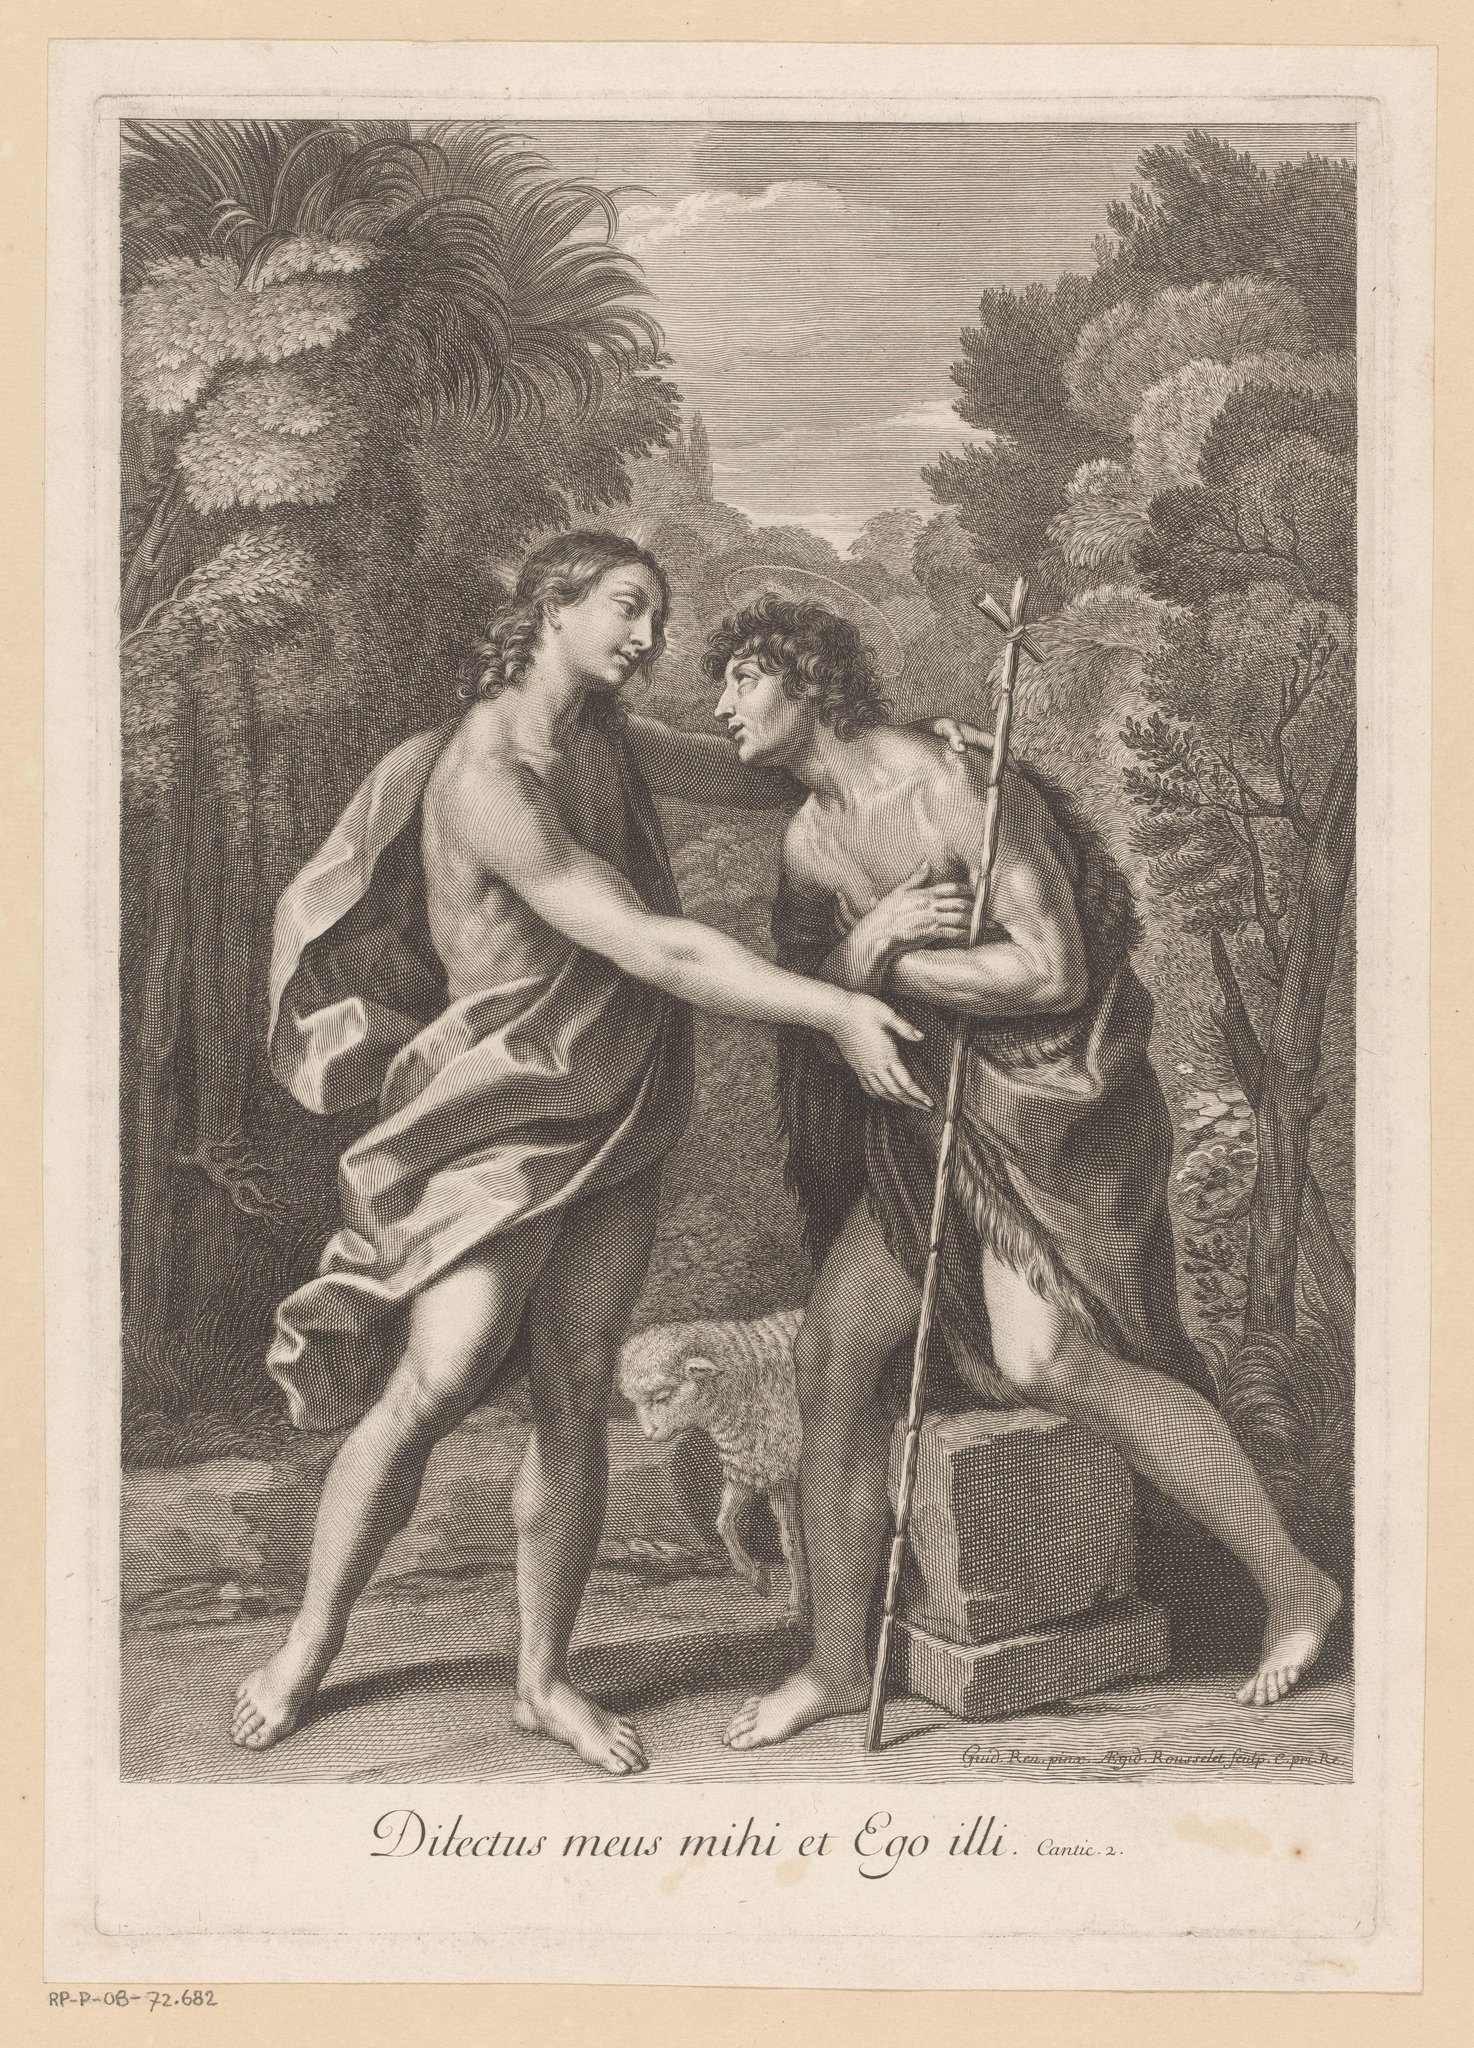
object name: print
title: Christus en Johannes de Doper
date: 1663-1666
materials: paper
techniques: engraving, etching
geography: france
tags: series of scenes from the life of john the baptist, series of scenes from the life of christ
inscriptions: collector's mark: Lugt 240